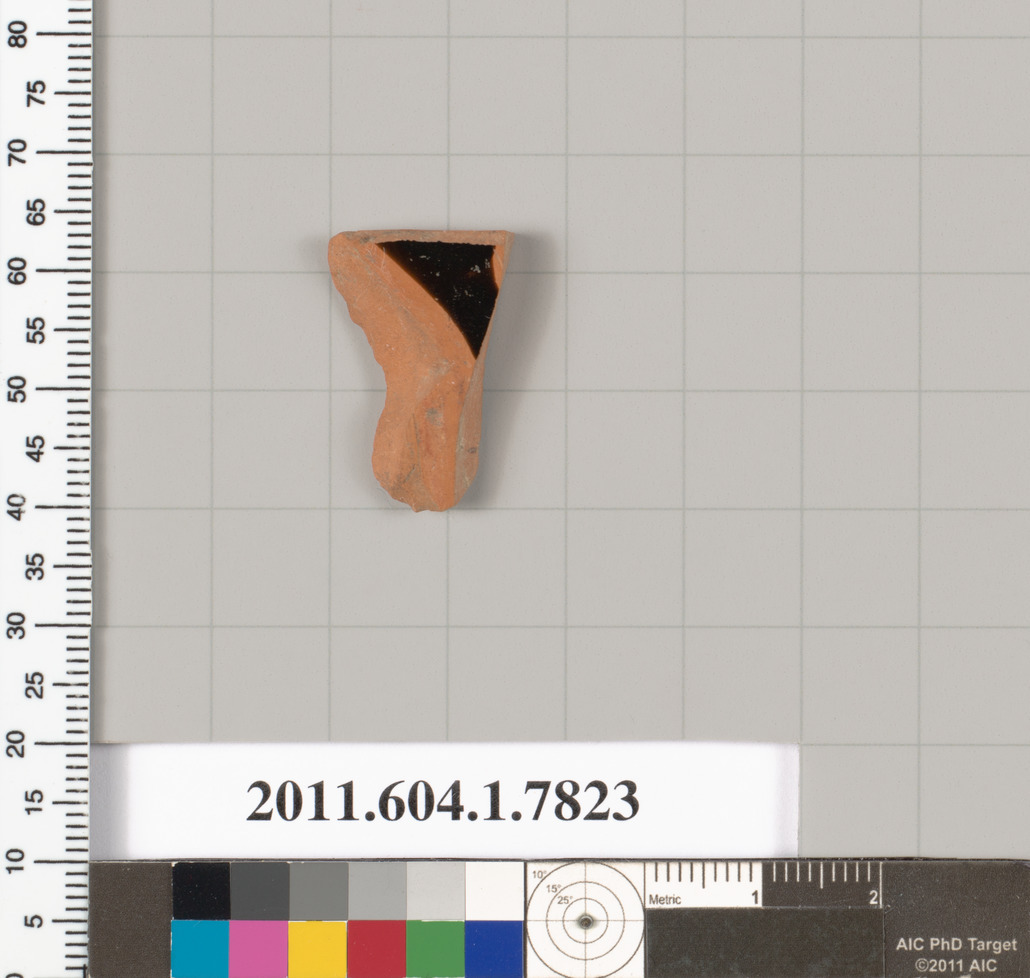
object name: kylix fragment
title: Terracotta fragment of a kylix (drinking cup)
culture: greek, attic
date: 460-450 BCE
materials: terracotta